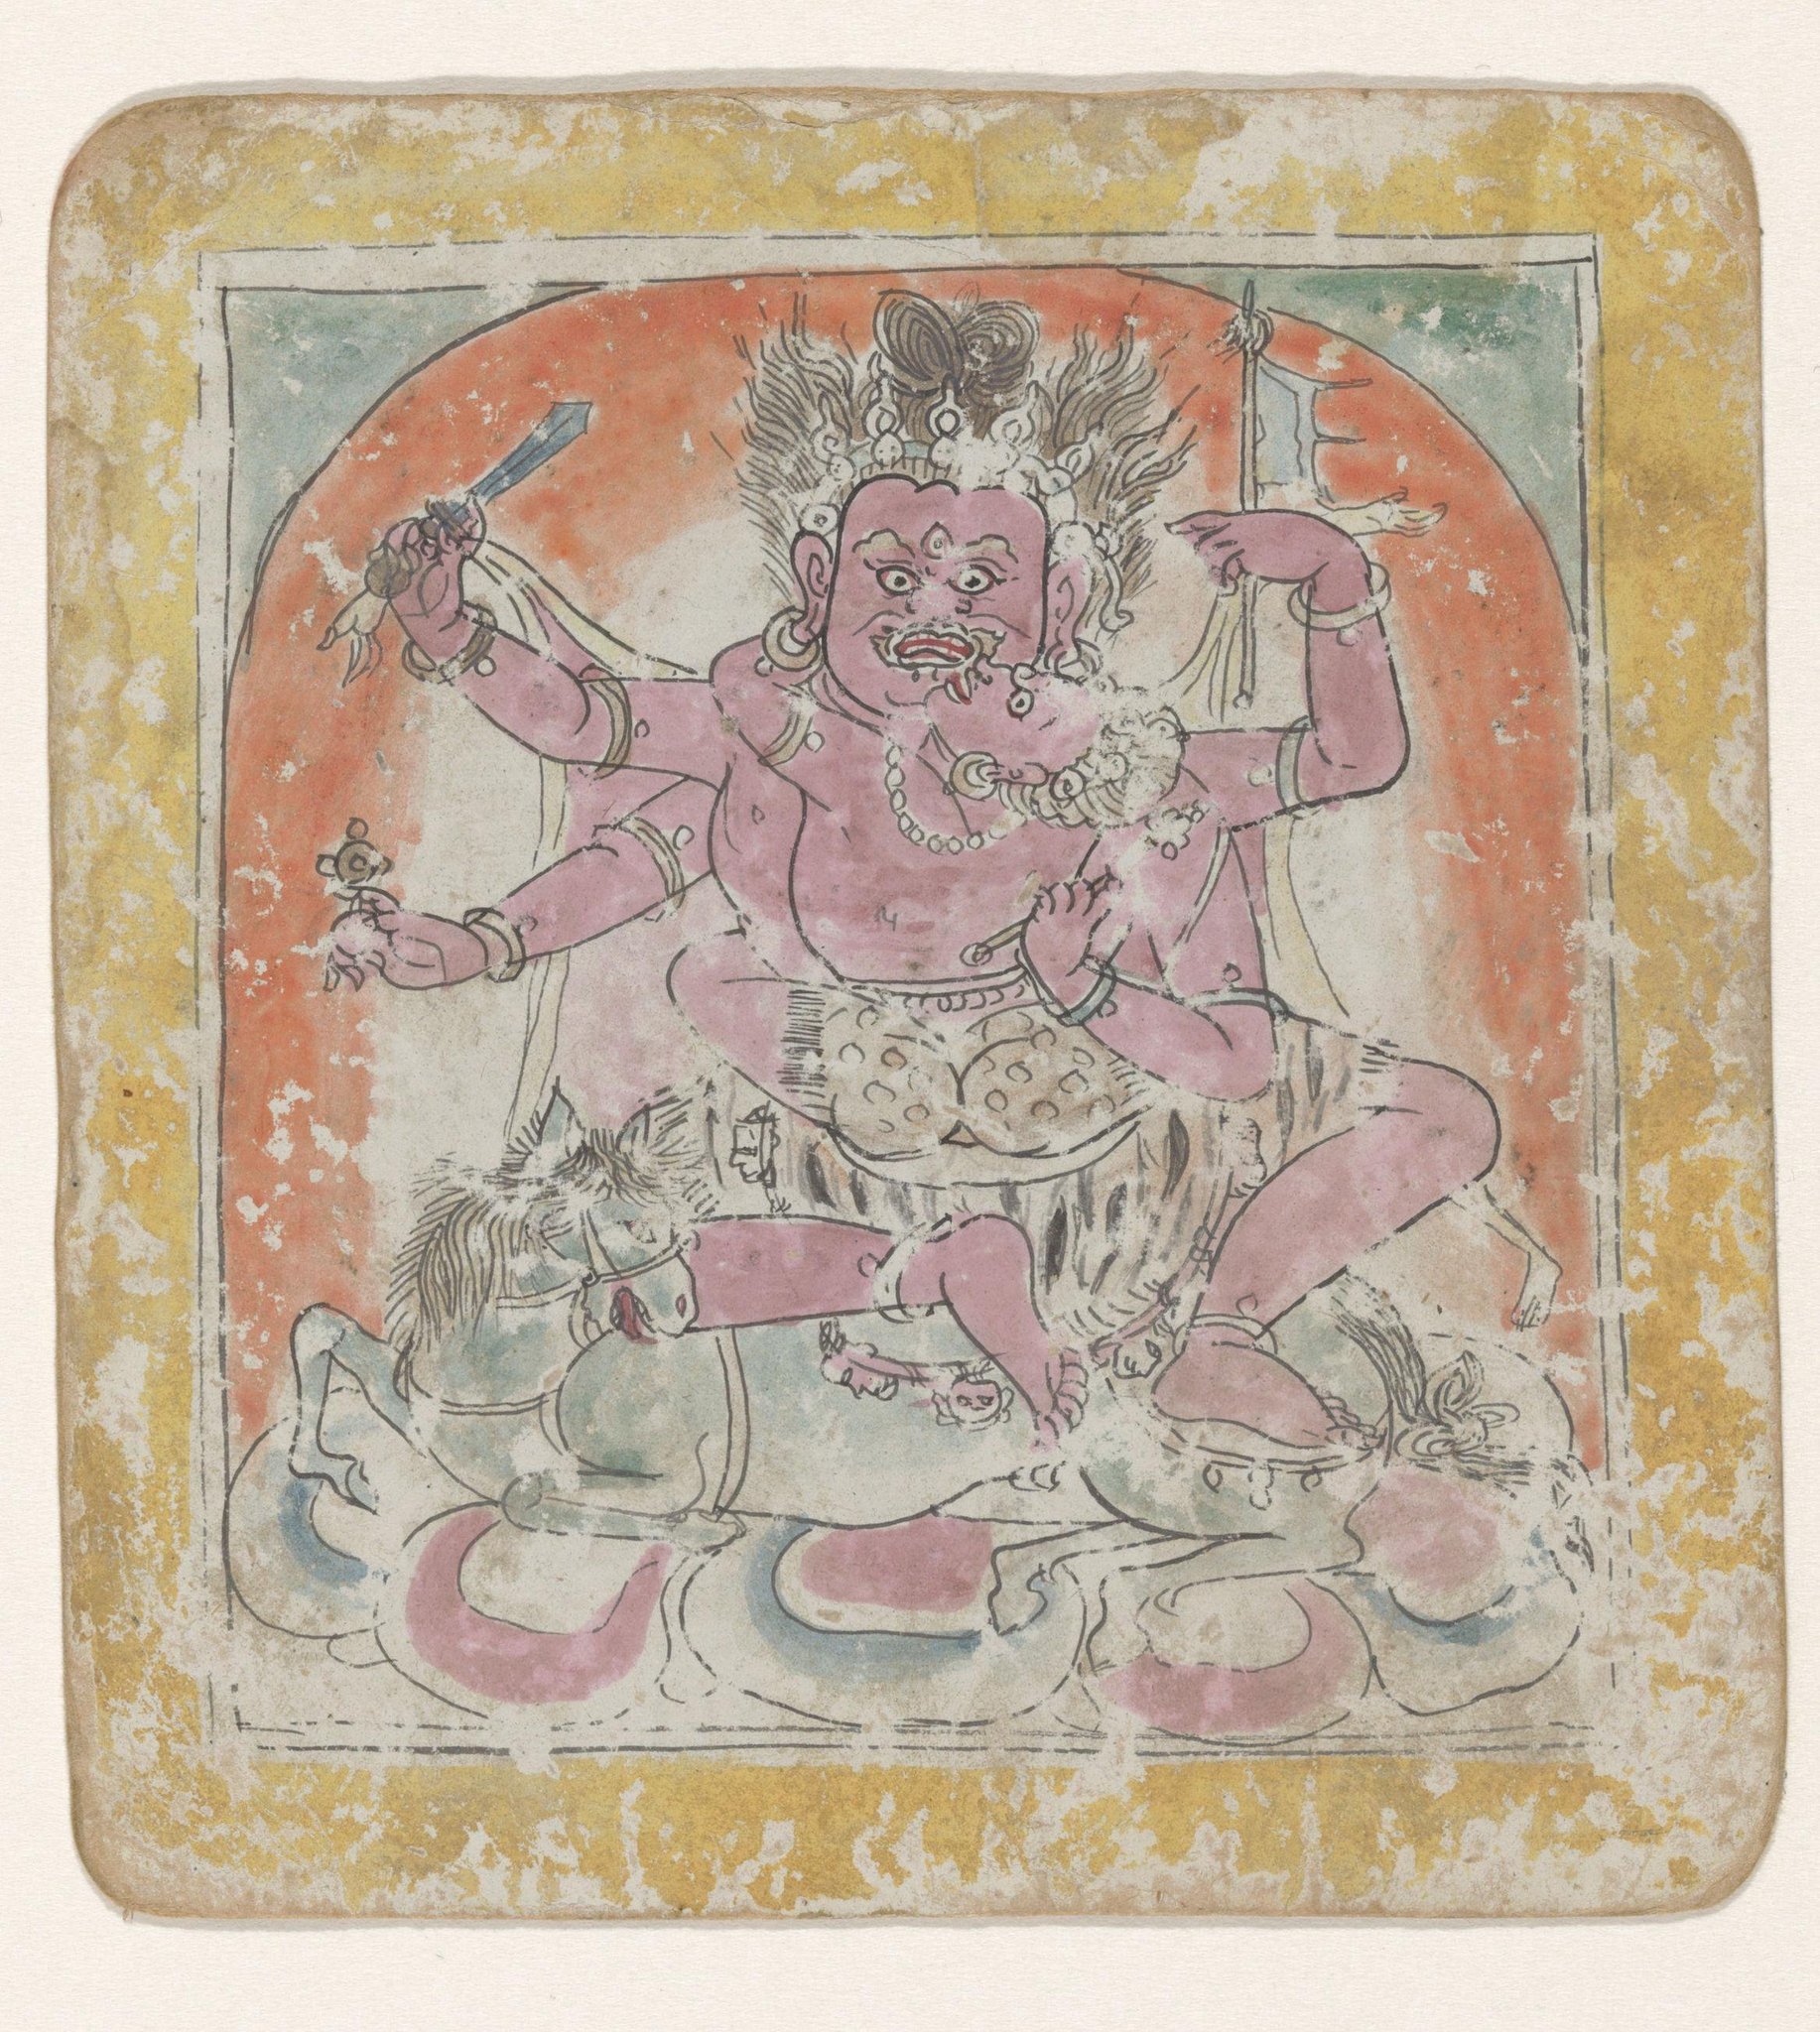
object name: drawing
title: Boeddhistische heiligen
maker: Anonymous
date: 1900-1970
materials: paper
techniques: brush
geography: tibet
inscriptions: inscription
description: Een mannelijk figuur omklemd door een vrouw, hij heeft twee paar armen en houdt in elke hand een ander voorwerp vast, beide figuren zitten op een paard. Een afbeelding uit een serie van drie waarop Boeddhistische heiligen voorkomen.